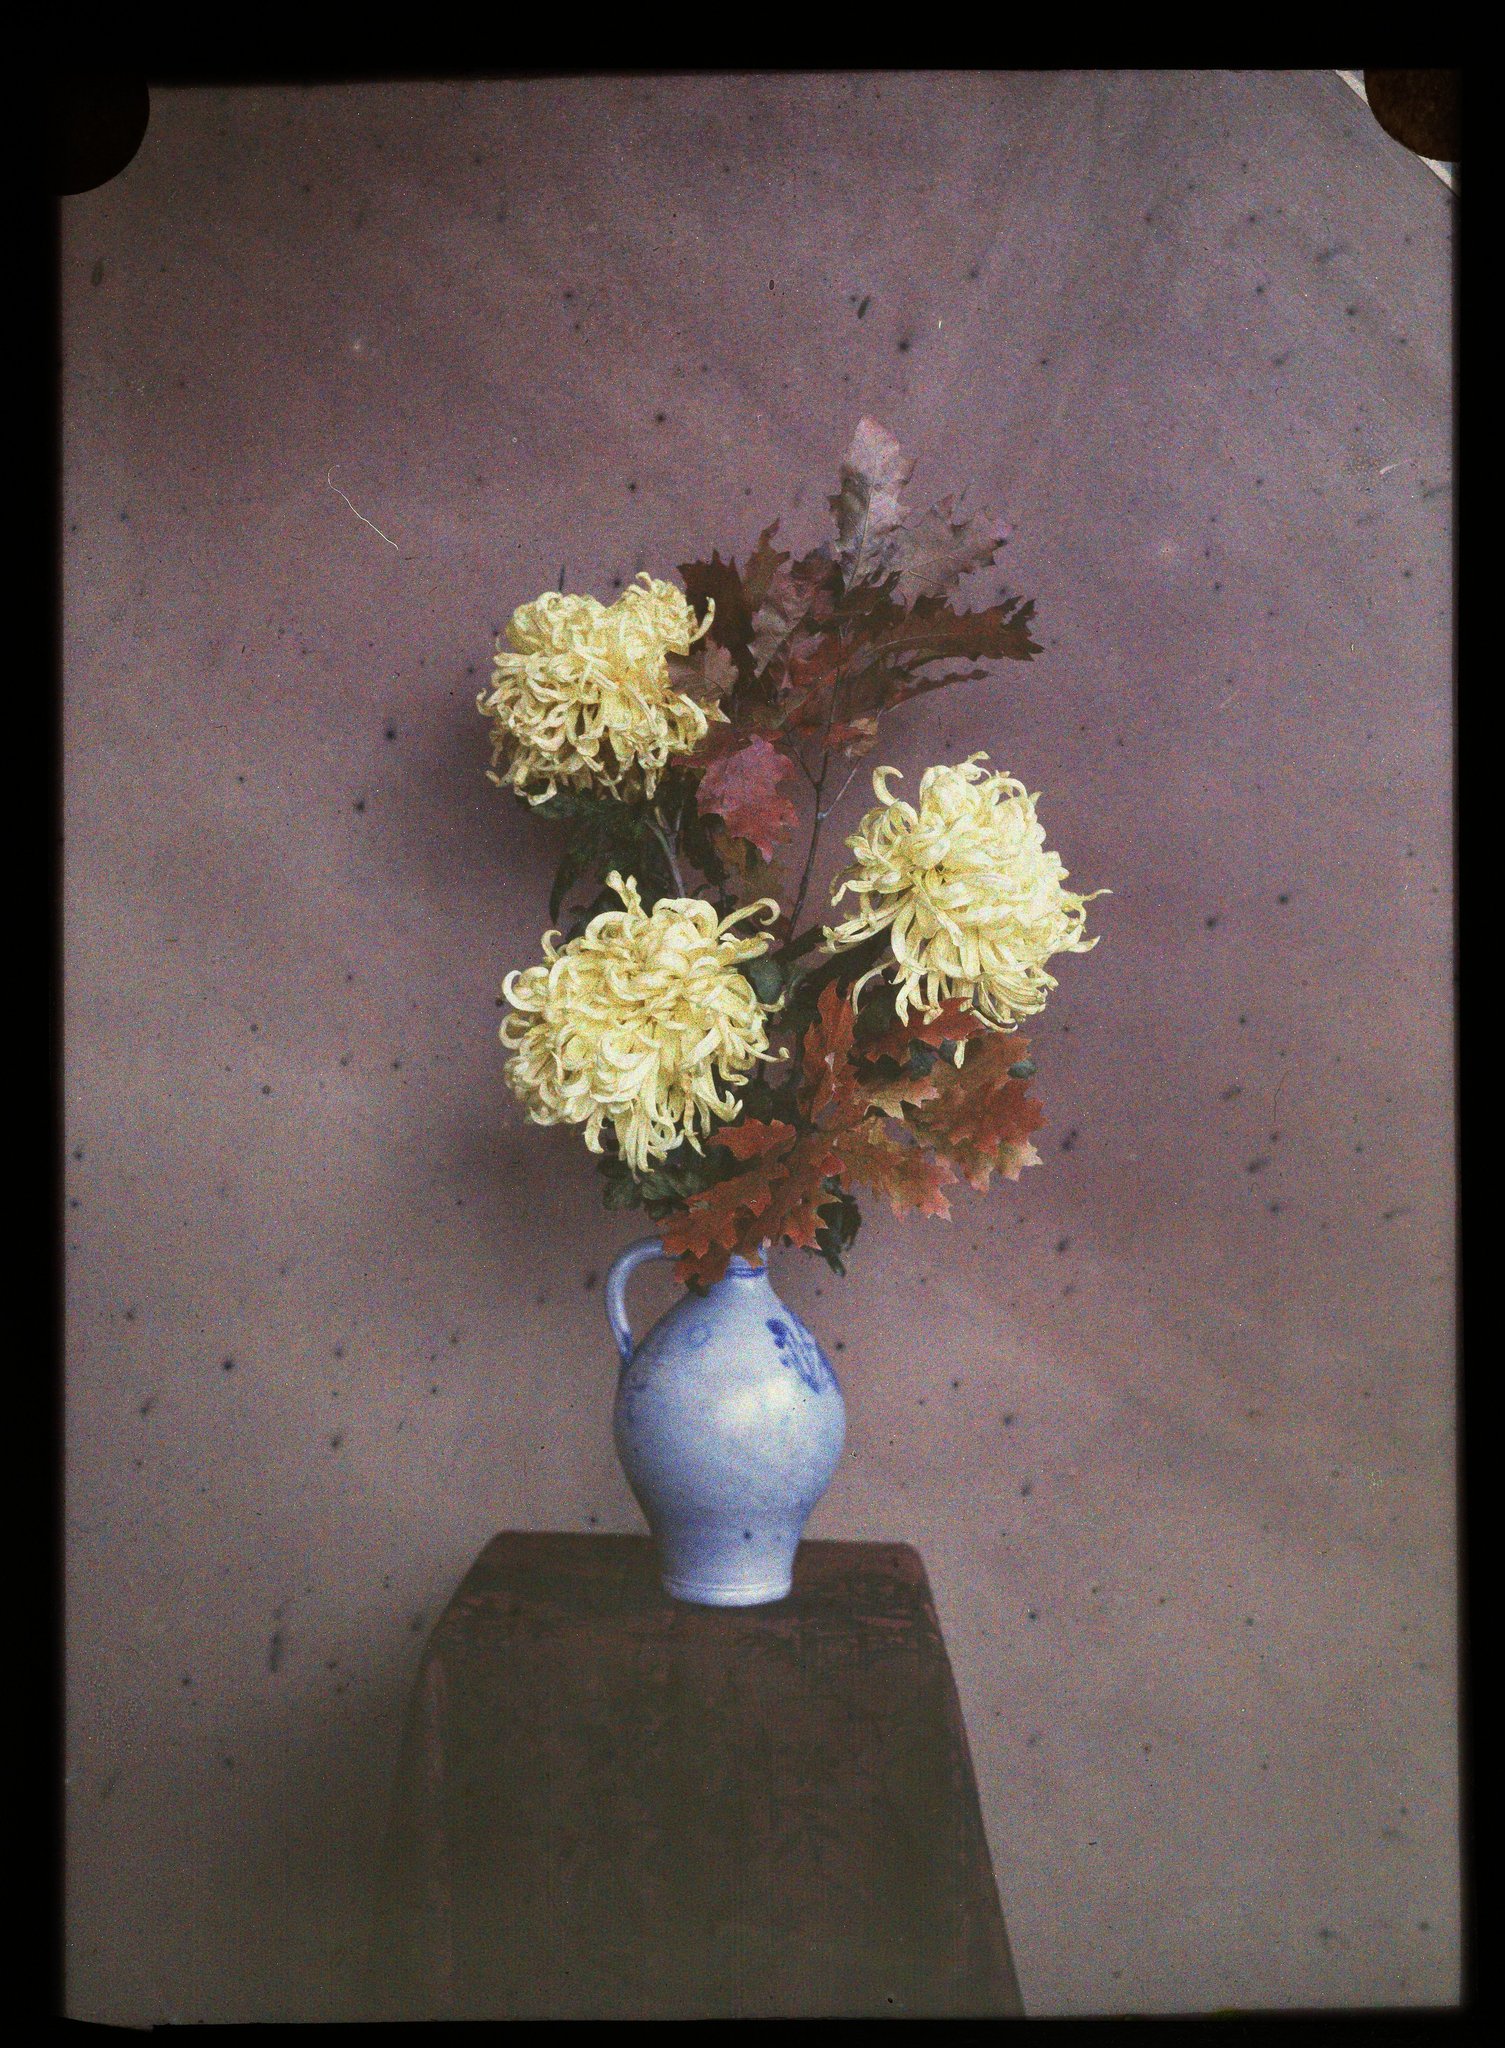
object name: glasdia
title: Bloemen (asters) op een vaas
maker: c.w. immink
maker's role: fotograaf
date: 1907-1935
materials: glass, paper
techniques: autochrome process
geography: netherlands